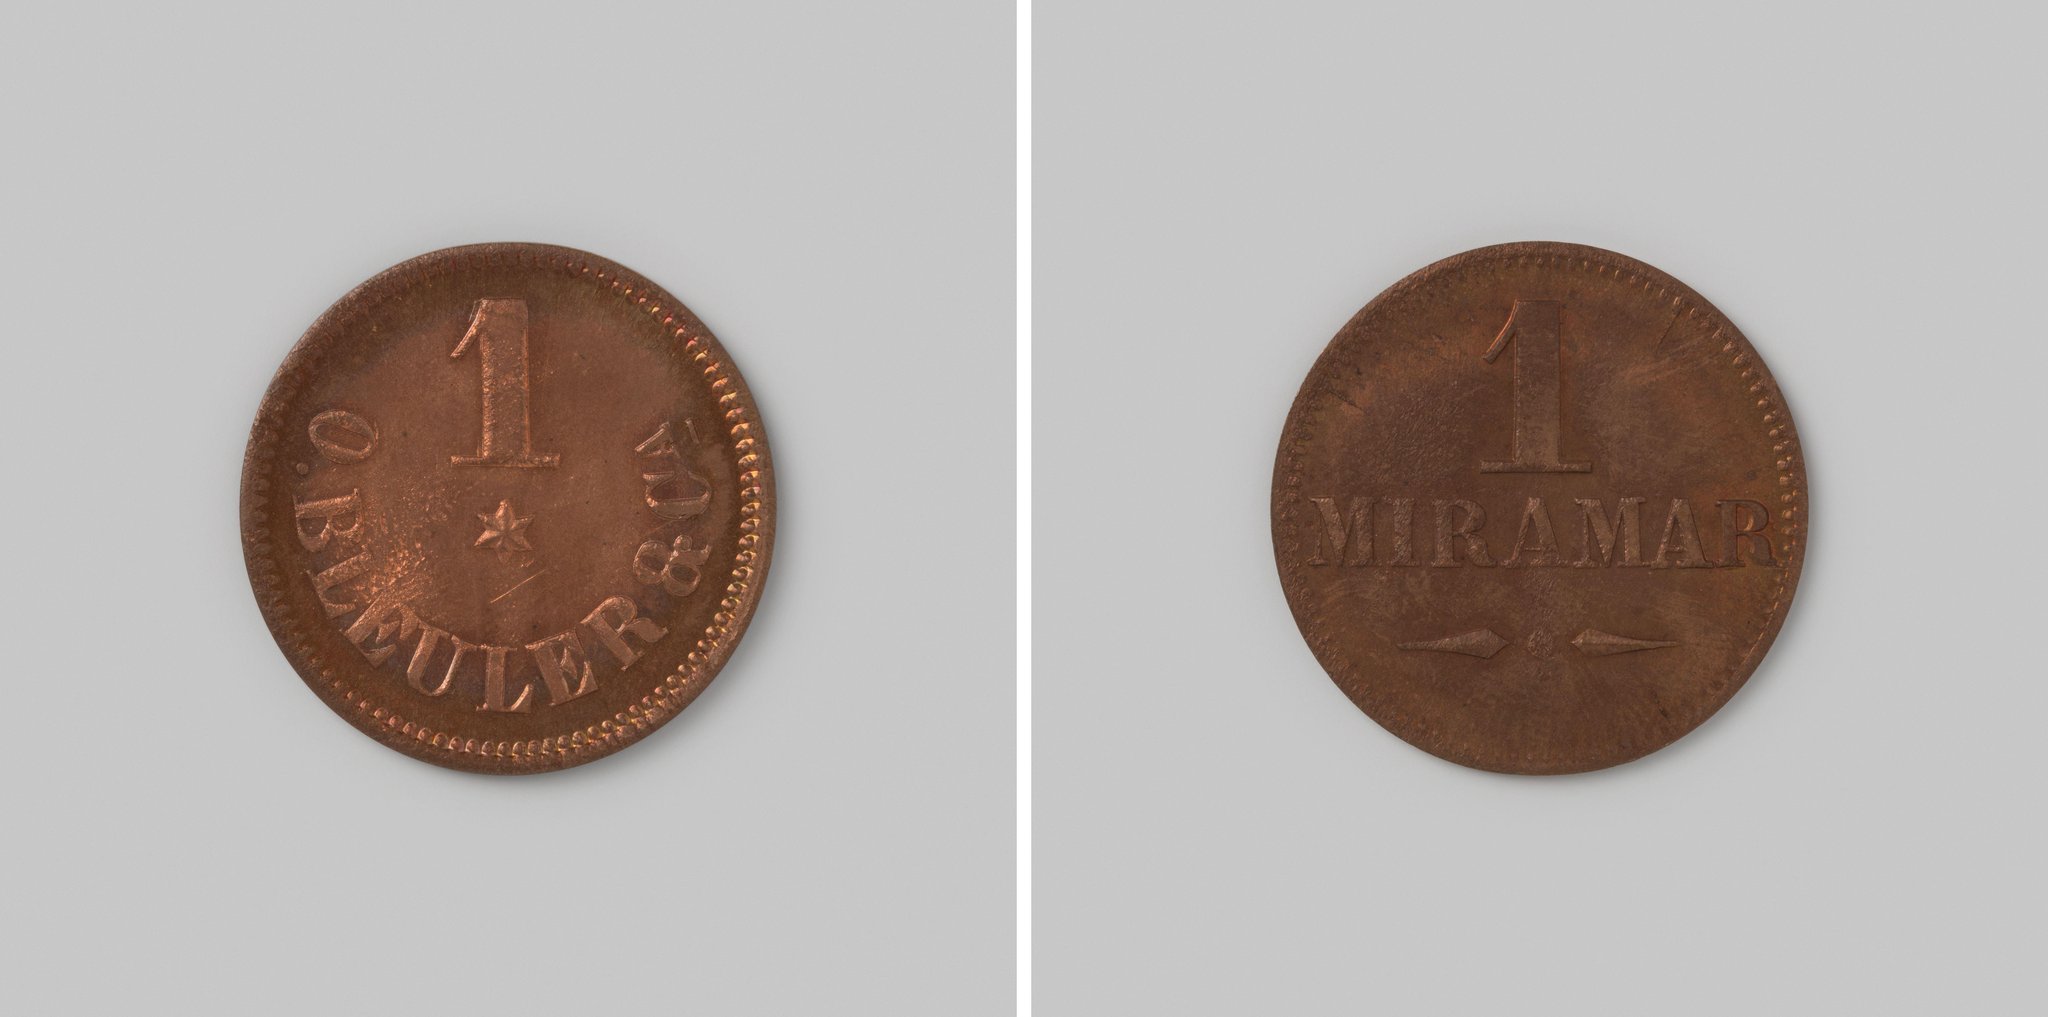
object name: coin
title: Particuliere munt van 1 reaal op naam van O. Bleuler & Co uit Miramar in Guatemala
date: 1800-1900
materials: copper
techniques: striking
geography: guatemala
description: Koperen particuliere munt. Voorzijde: waarde-aanduiding:1. In omschrift firma-aanduiding. Keerzijde: waarde-aanduiding:1. In omschrift plaats-aanduiding. Gladde rand.